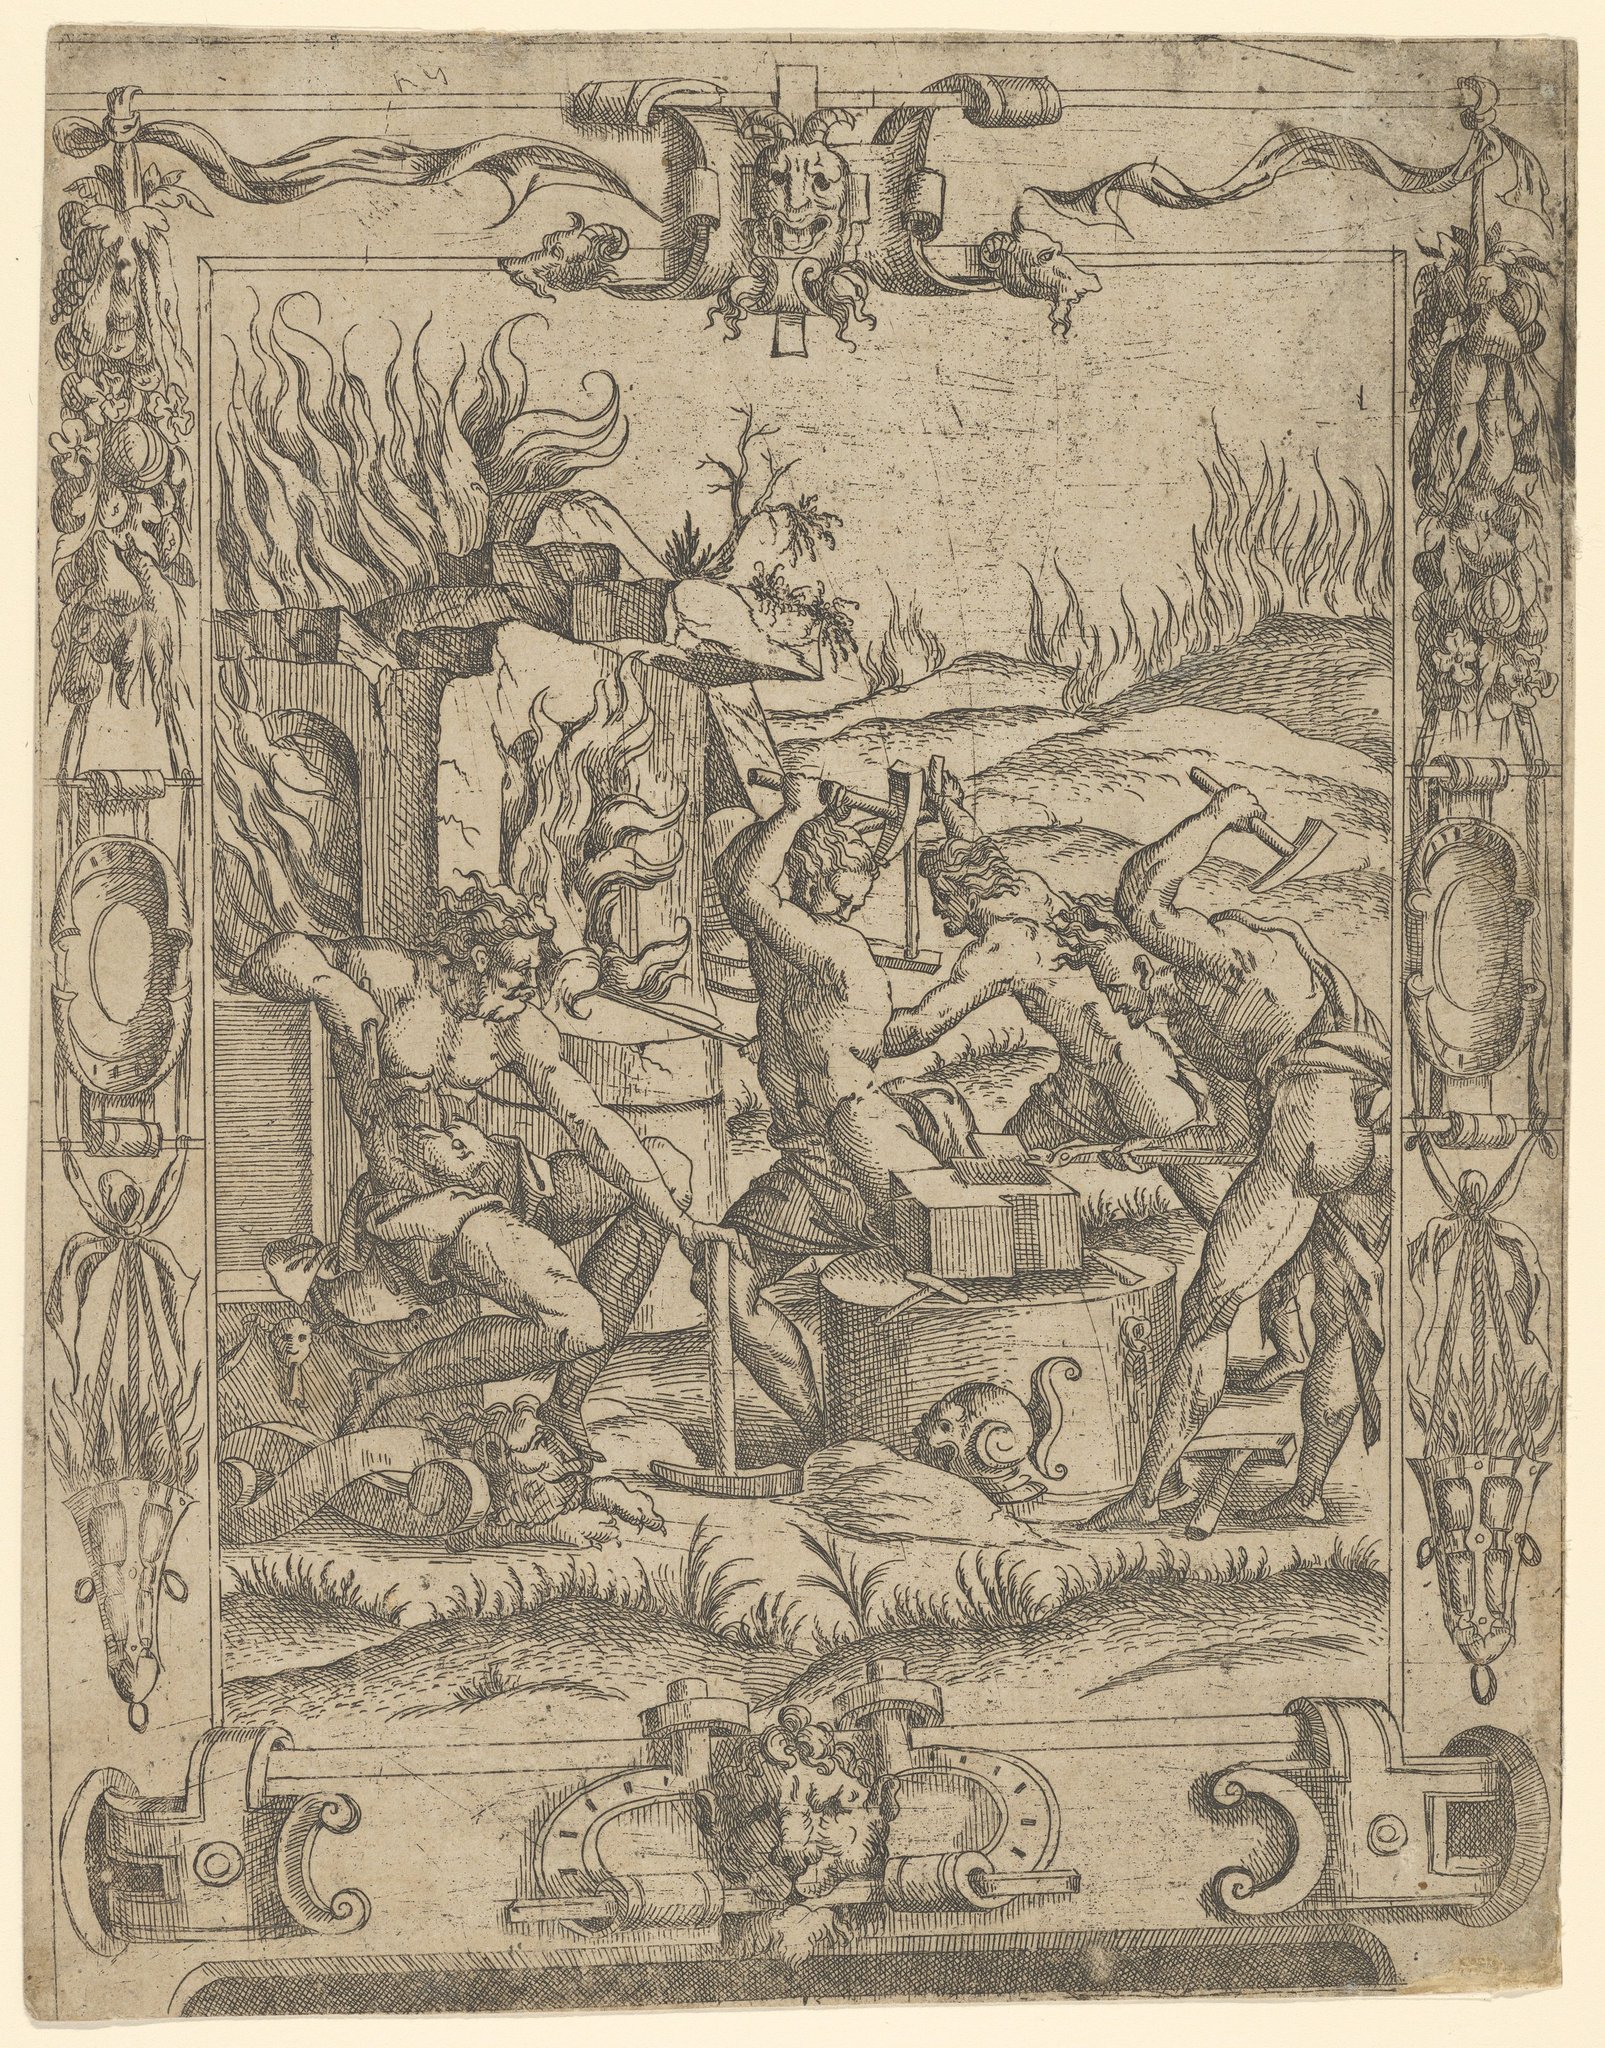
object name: print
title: Vulcan's Forge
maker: master iqv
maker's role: artist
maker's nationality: french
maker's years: 1500-1600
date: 1542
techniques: etching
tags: vulcan,working